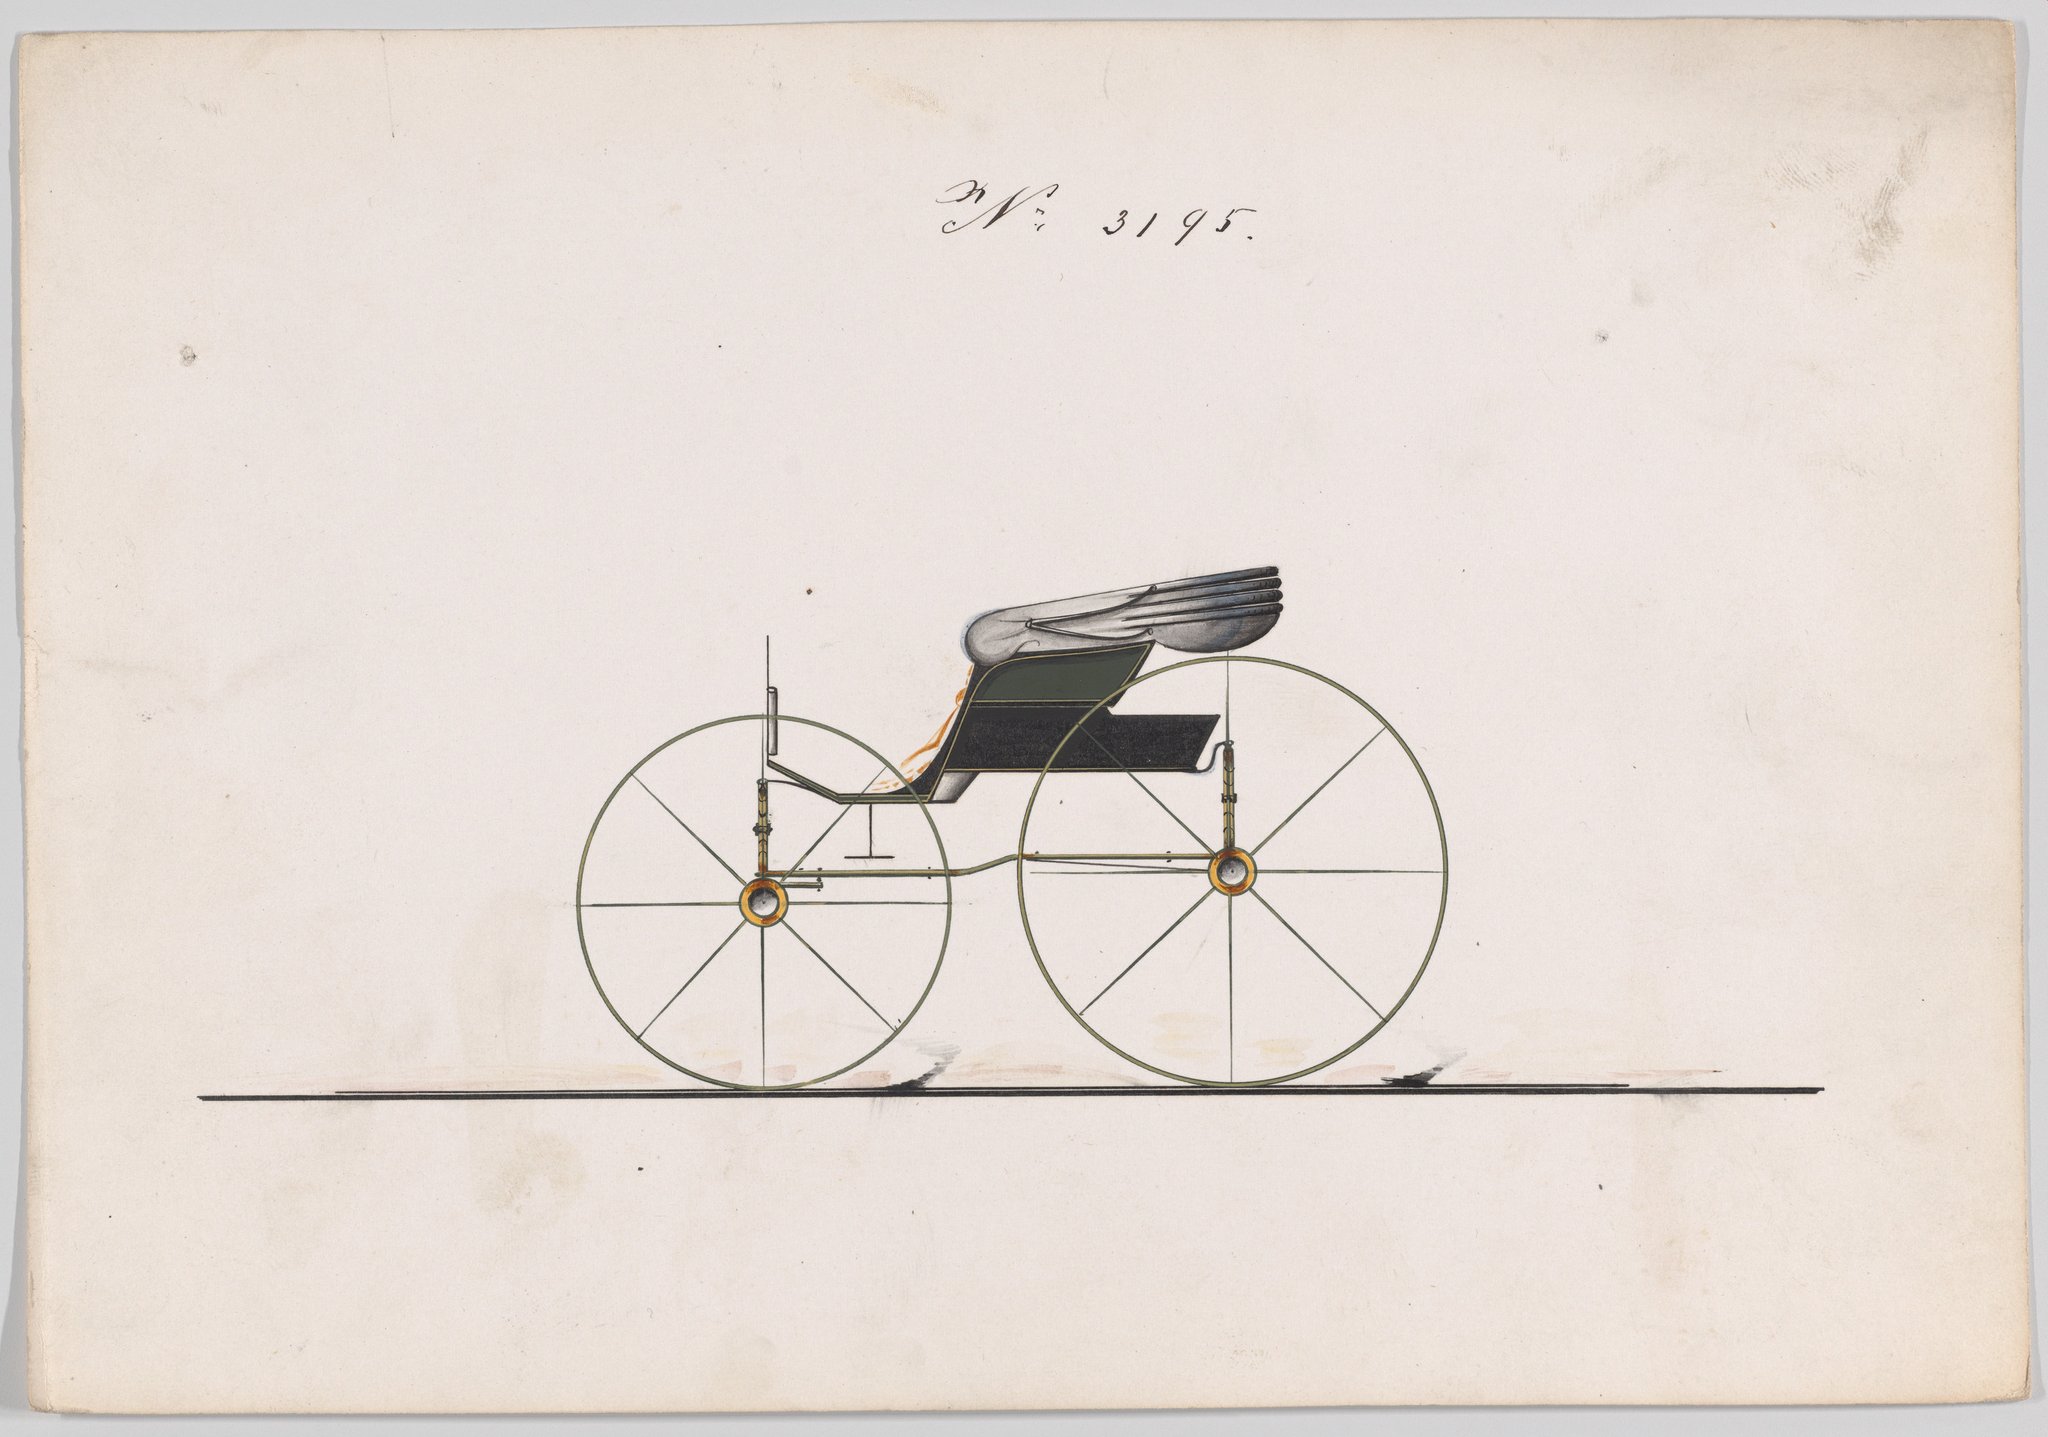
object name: drawing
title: Design for Pony Phaeton, no. 3195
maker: brewster & co.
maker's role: manufacturer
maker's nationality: american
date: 1876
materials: gouache, ink, watercolor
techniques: pen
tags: carriages